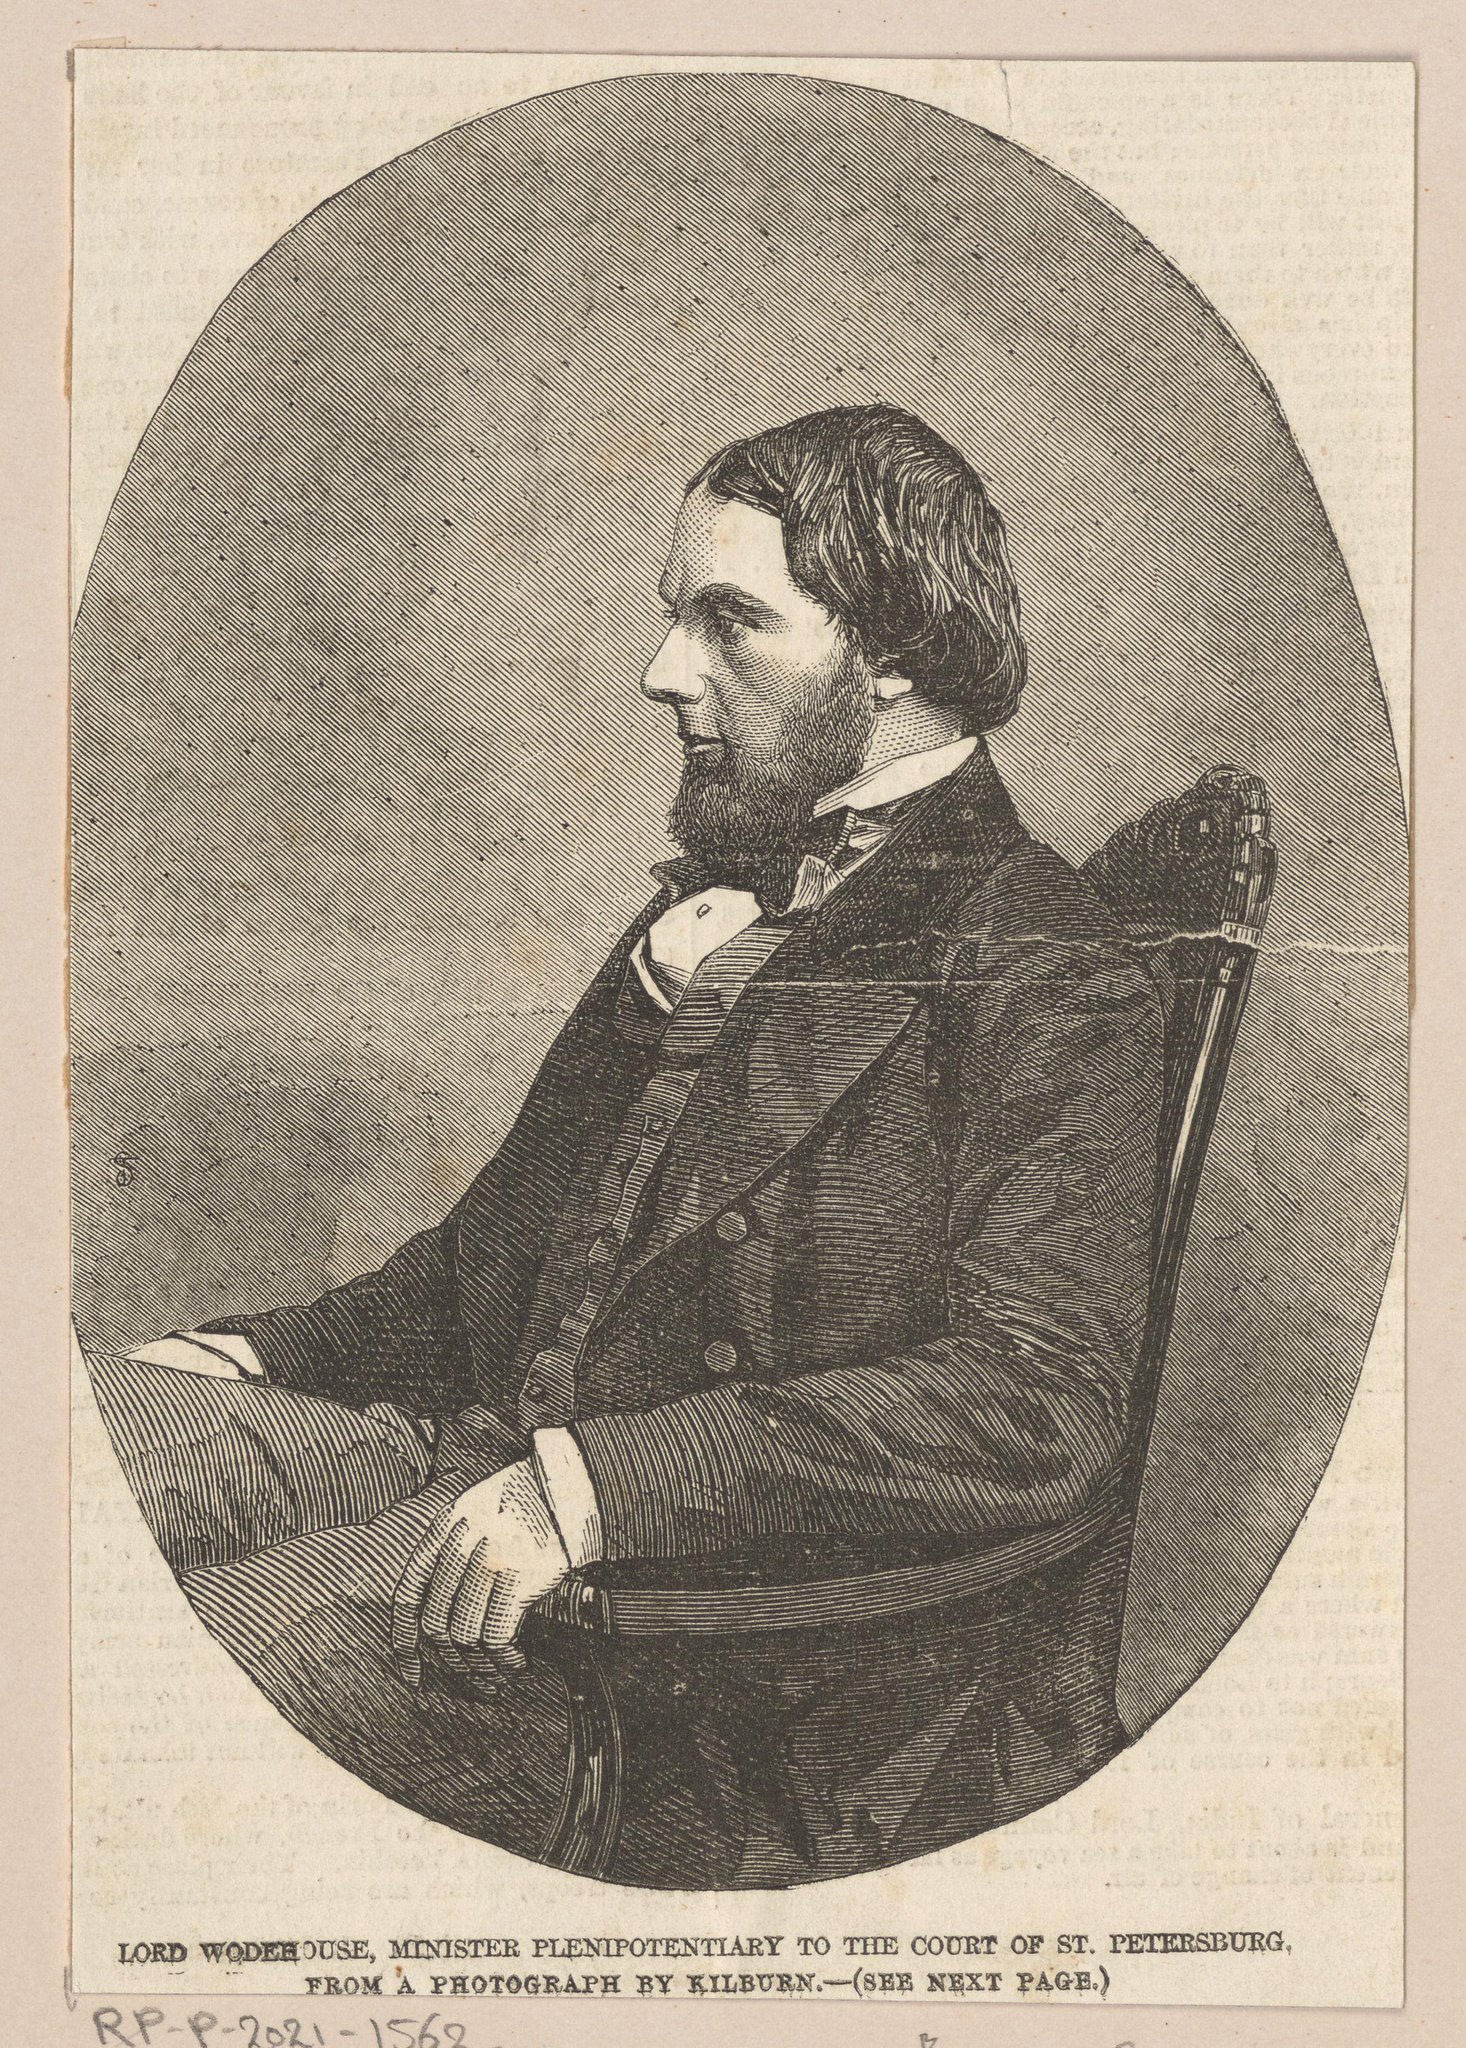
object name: print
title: Portret van John Wodehouse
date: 1856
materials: paper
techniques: letterpress printing, engraving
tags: historical persons, sitting on an elevation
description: Prent mogelijk uit: The Illustrated London News, 6 september 1856.